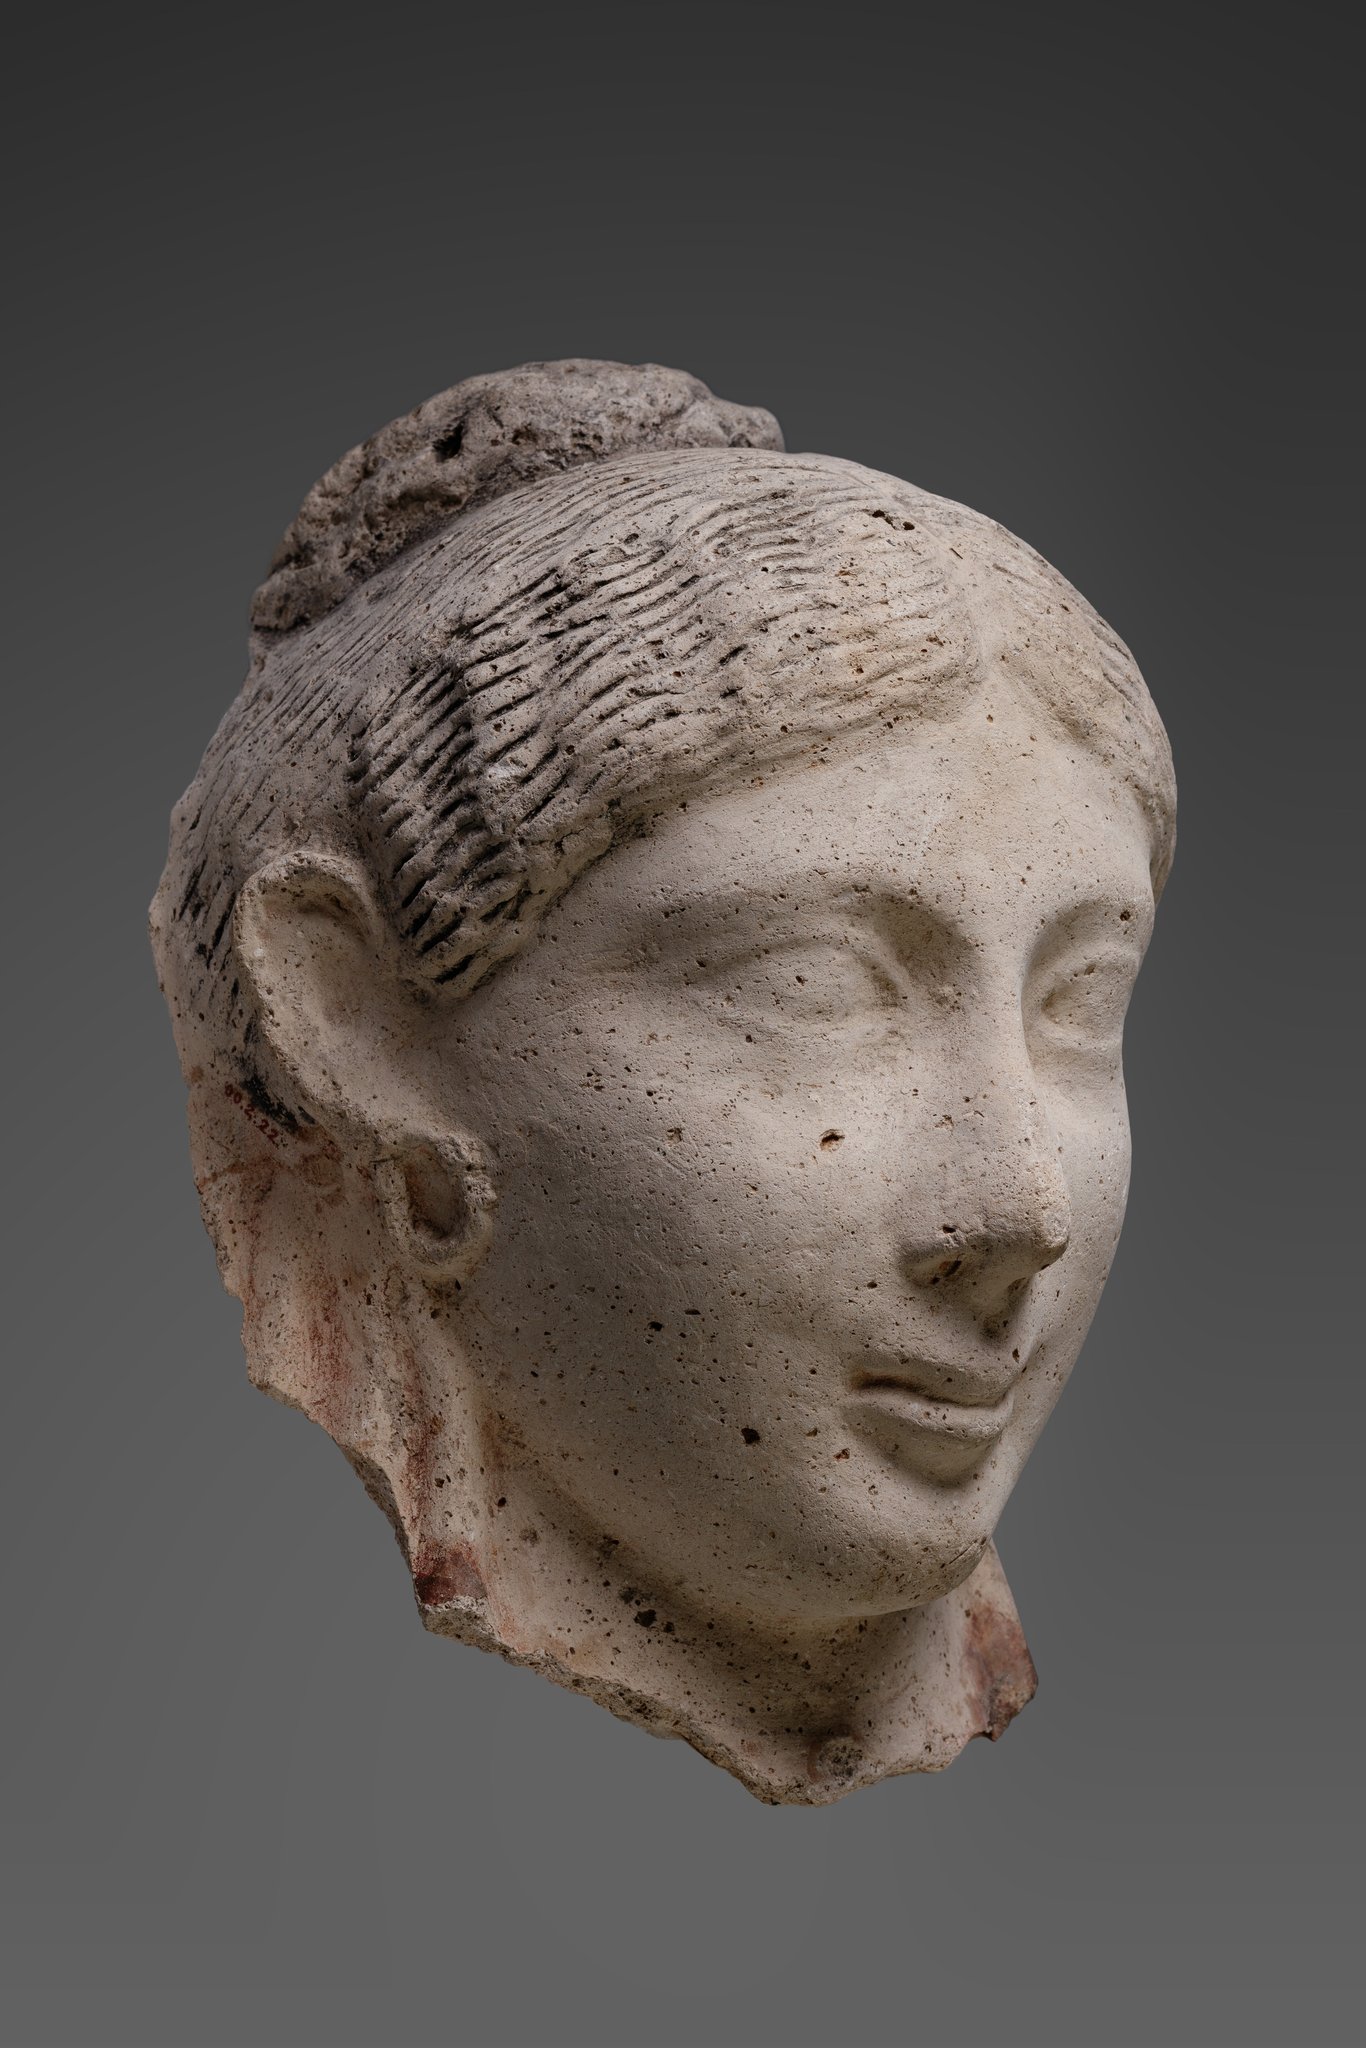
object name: mask, woman, austere hairstyle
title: Mask of a woman with an austere hairstyle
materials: paint, plaster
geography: egypt